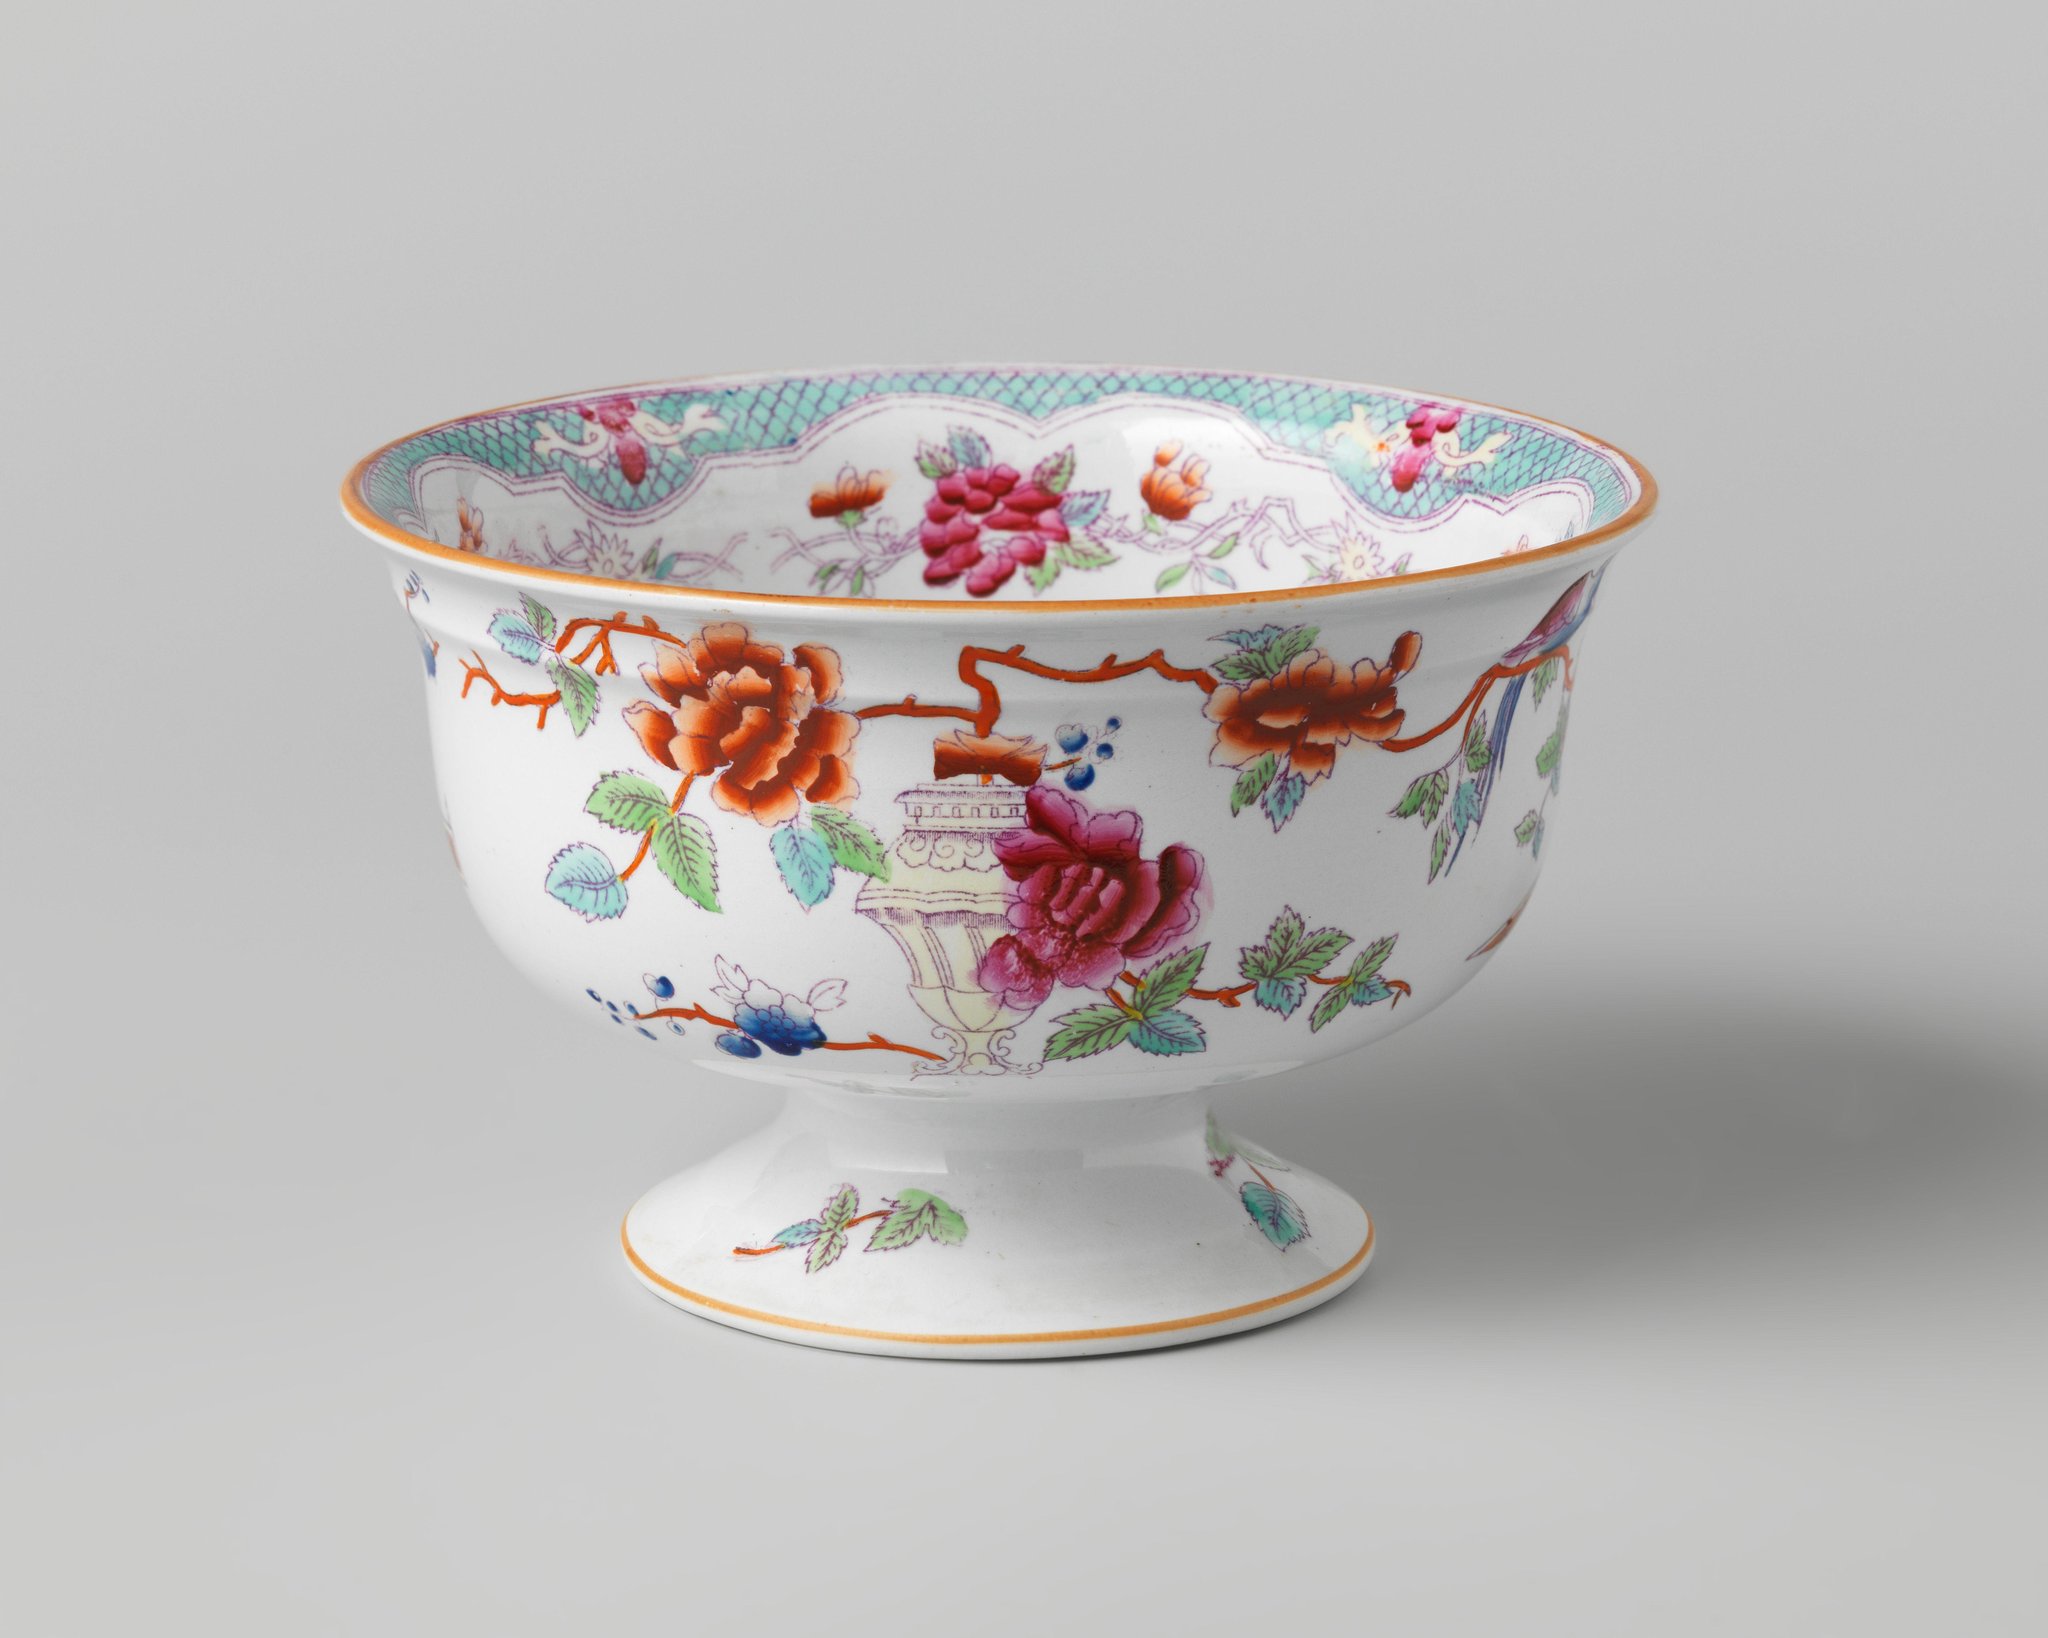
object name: kastkom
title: Kastkom, met veelkleurig decor met twee tuinvazen, hekwerk, bloemtakken en een vogel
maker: petrus regout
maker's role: plateelbakker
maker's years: 1801-1879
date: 1860-1890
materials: creamware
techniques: muffling, transfer decoration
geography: maastricht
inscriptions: mark: ‘PORTICI // PIERRE REGOUT’, check stamp: ‘P. REGOUT // MAASTRICHT // X’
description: Kastkom op voet van aardewerk, met roze bovenglazuur transferdecor met moffelkleuren. De wand aan de buitenzijde met veelkleurig decor met twee tuinvazen, hekwerk, bloemtakken en een vogel. De bovenrand en de voetrand met een oranje bies. Op de bodem van de kom een tuinvaas, een hek, een tak met bloemen en een vogel. Aan de binnenzijde van de wand takken met bloemen en bladeren, waarboven een band met hekwerk.